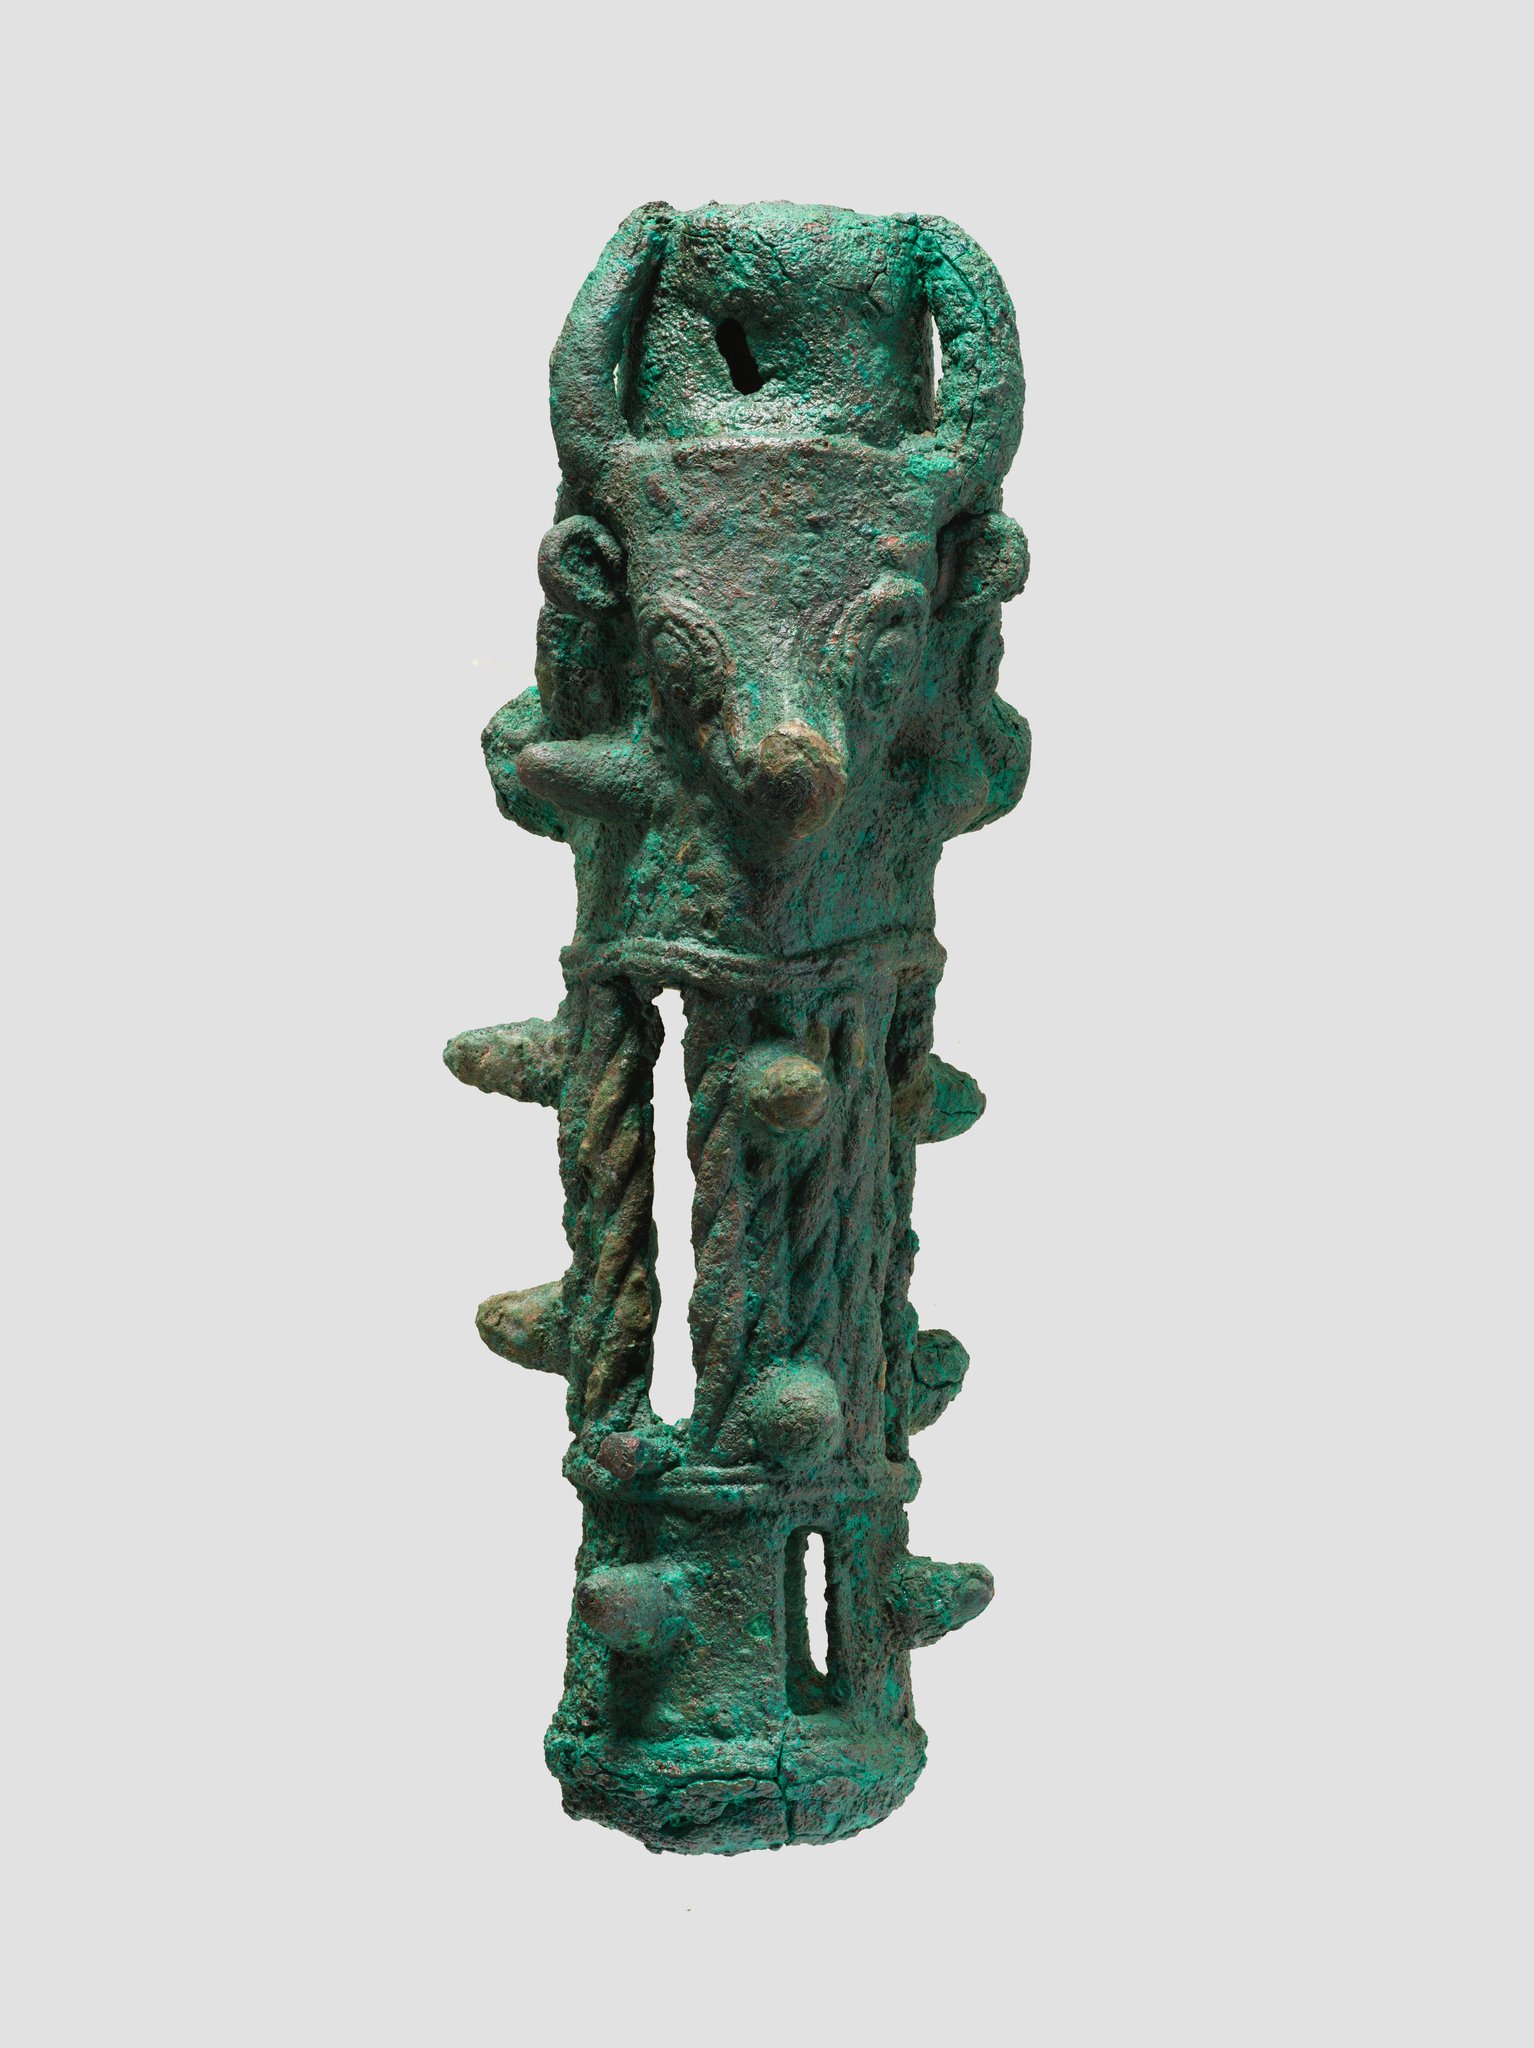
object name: mace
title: Mace heads in the form of triple bulls' heads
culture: iranian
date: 1333-668 BCE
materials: bronze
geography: western iran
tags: bulls